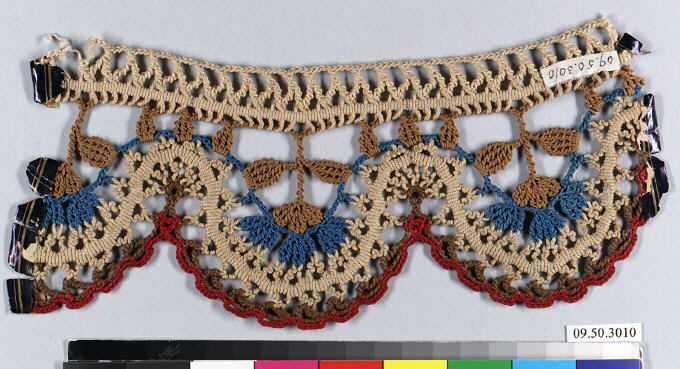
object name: piece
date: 1801-1900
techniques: crochet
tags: leaves